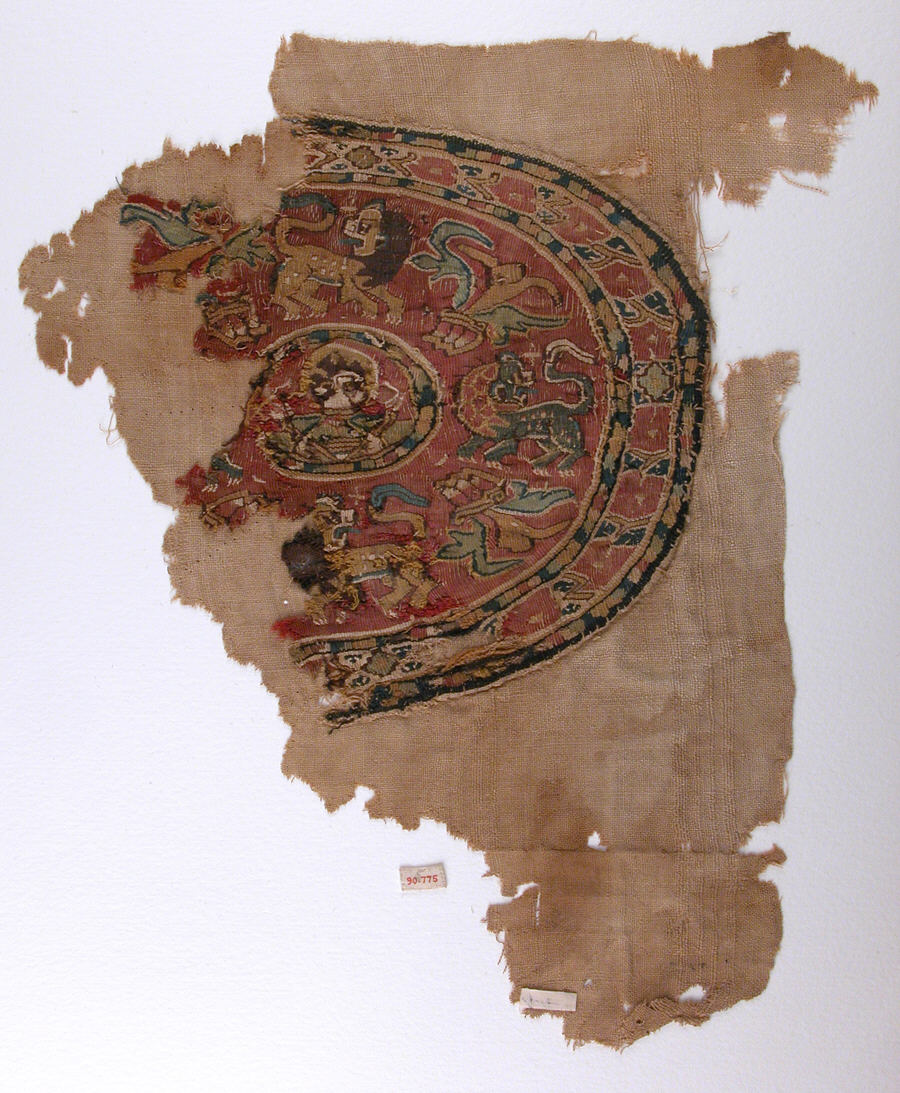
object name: textile fragment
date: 501-700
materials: linen, wool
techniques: weave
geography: egypt